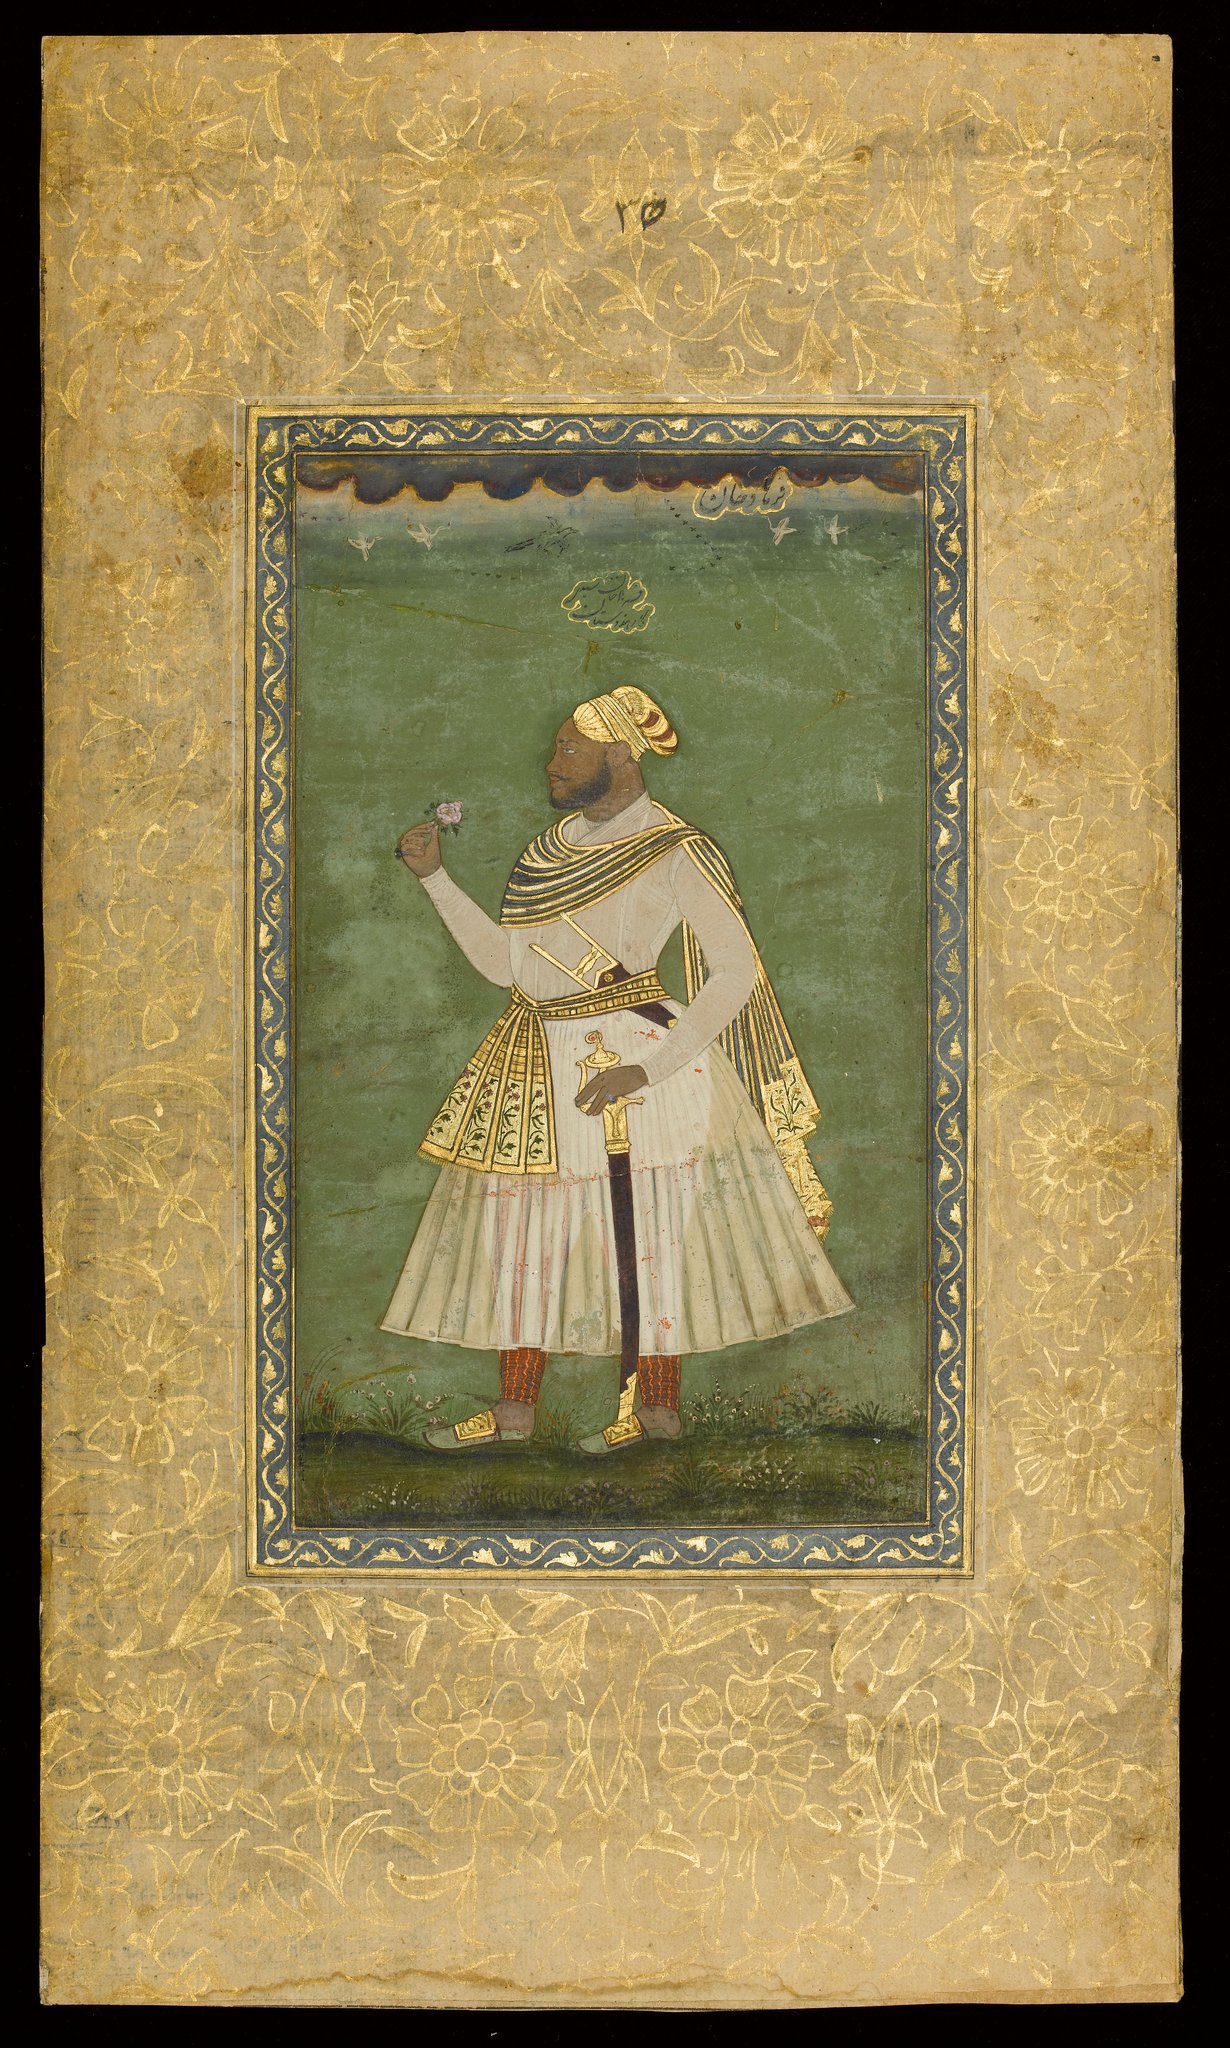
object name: illustrated album leaf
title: A Portrait of Farhad Khan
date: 1680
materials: gold, paper, watercolor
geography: india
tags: men,portraits